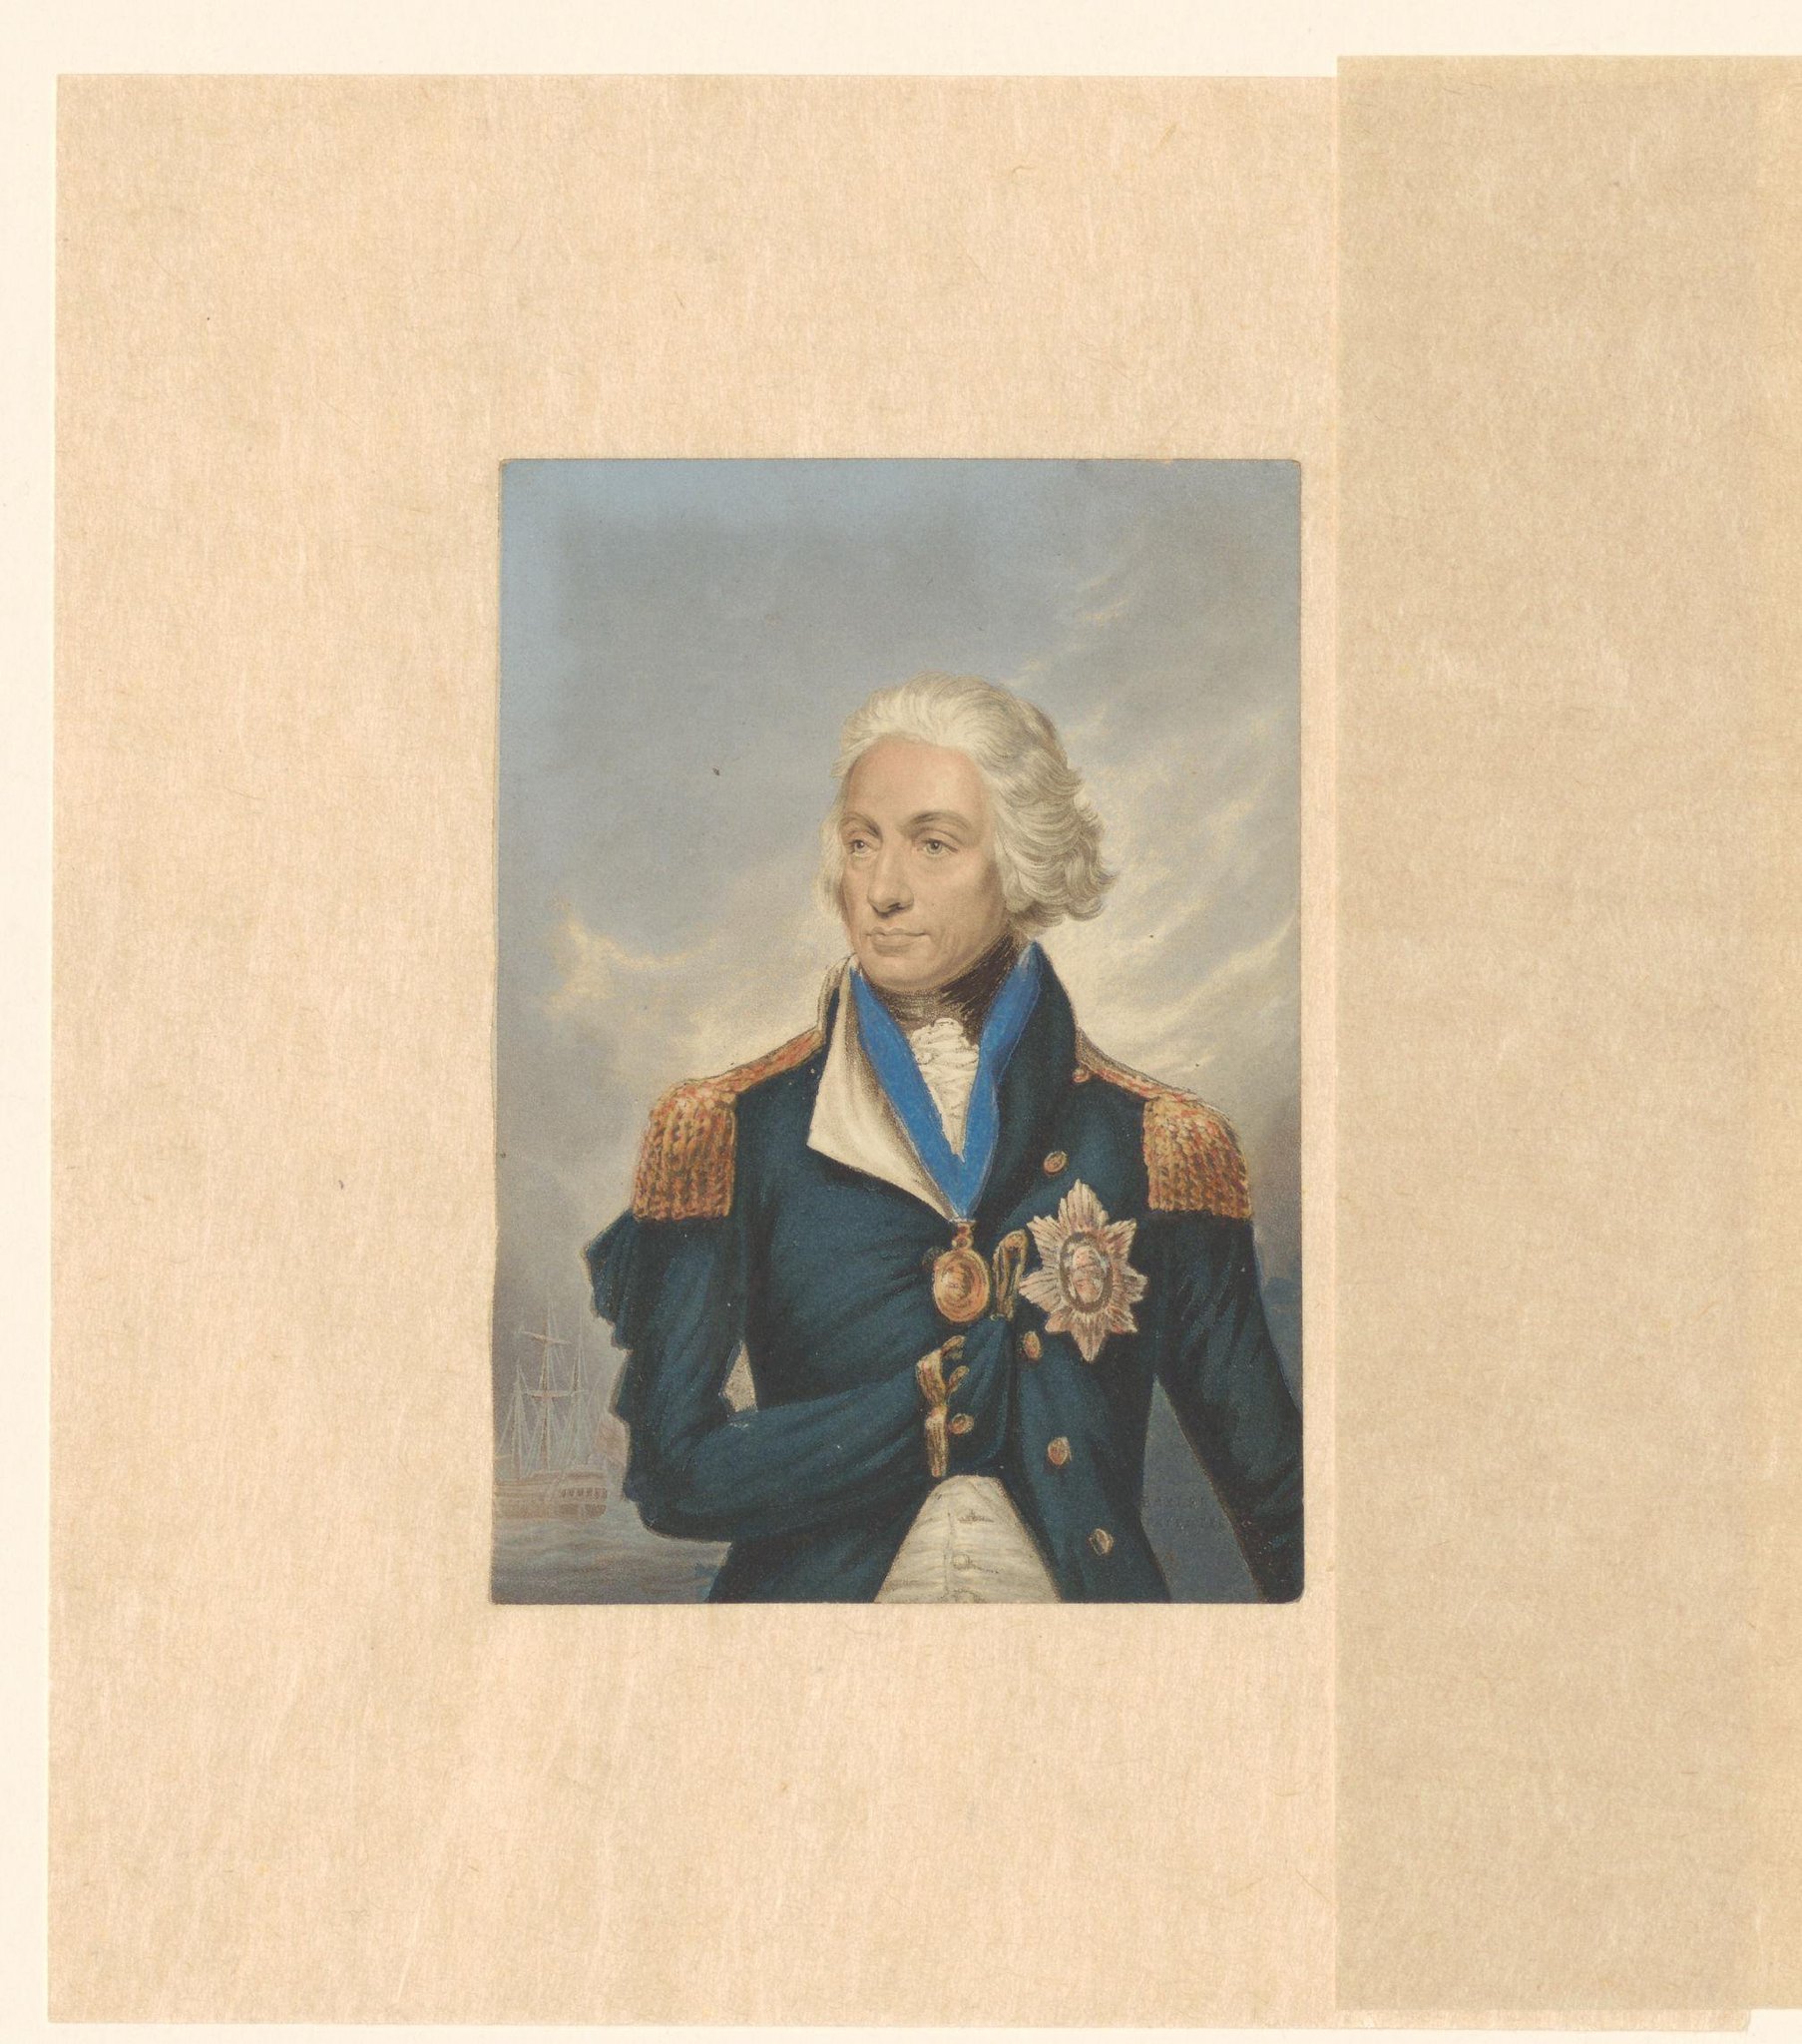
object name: print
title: Portret van Horatio Nelson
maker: george baxter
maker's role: print maker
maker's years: 1804-1867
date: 1834-1867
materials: paper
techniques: aquatint, printmaking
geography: england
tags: horatio nelson (hertog van bronte), historical persons, commander-in-chief, admiral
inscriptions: collector's mark: Lugt 2760, collector's mark: Lugt 2228